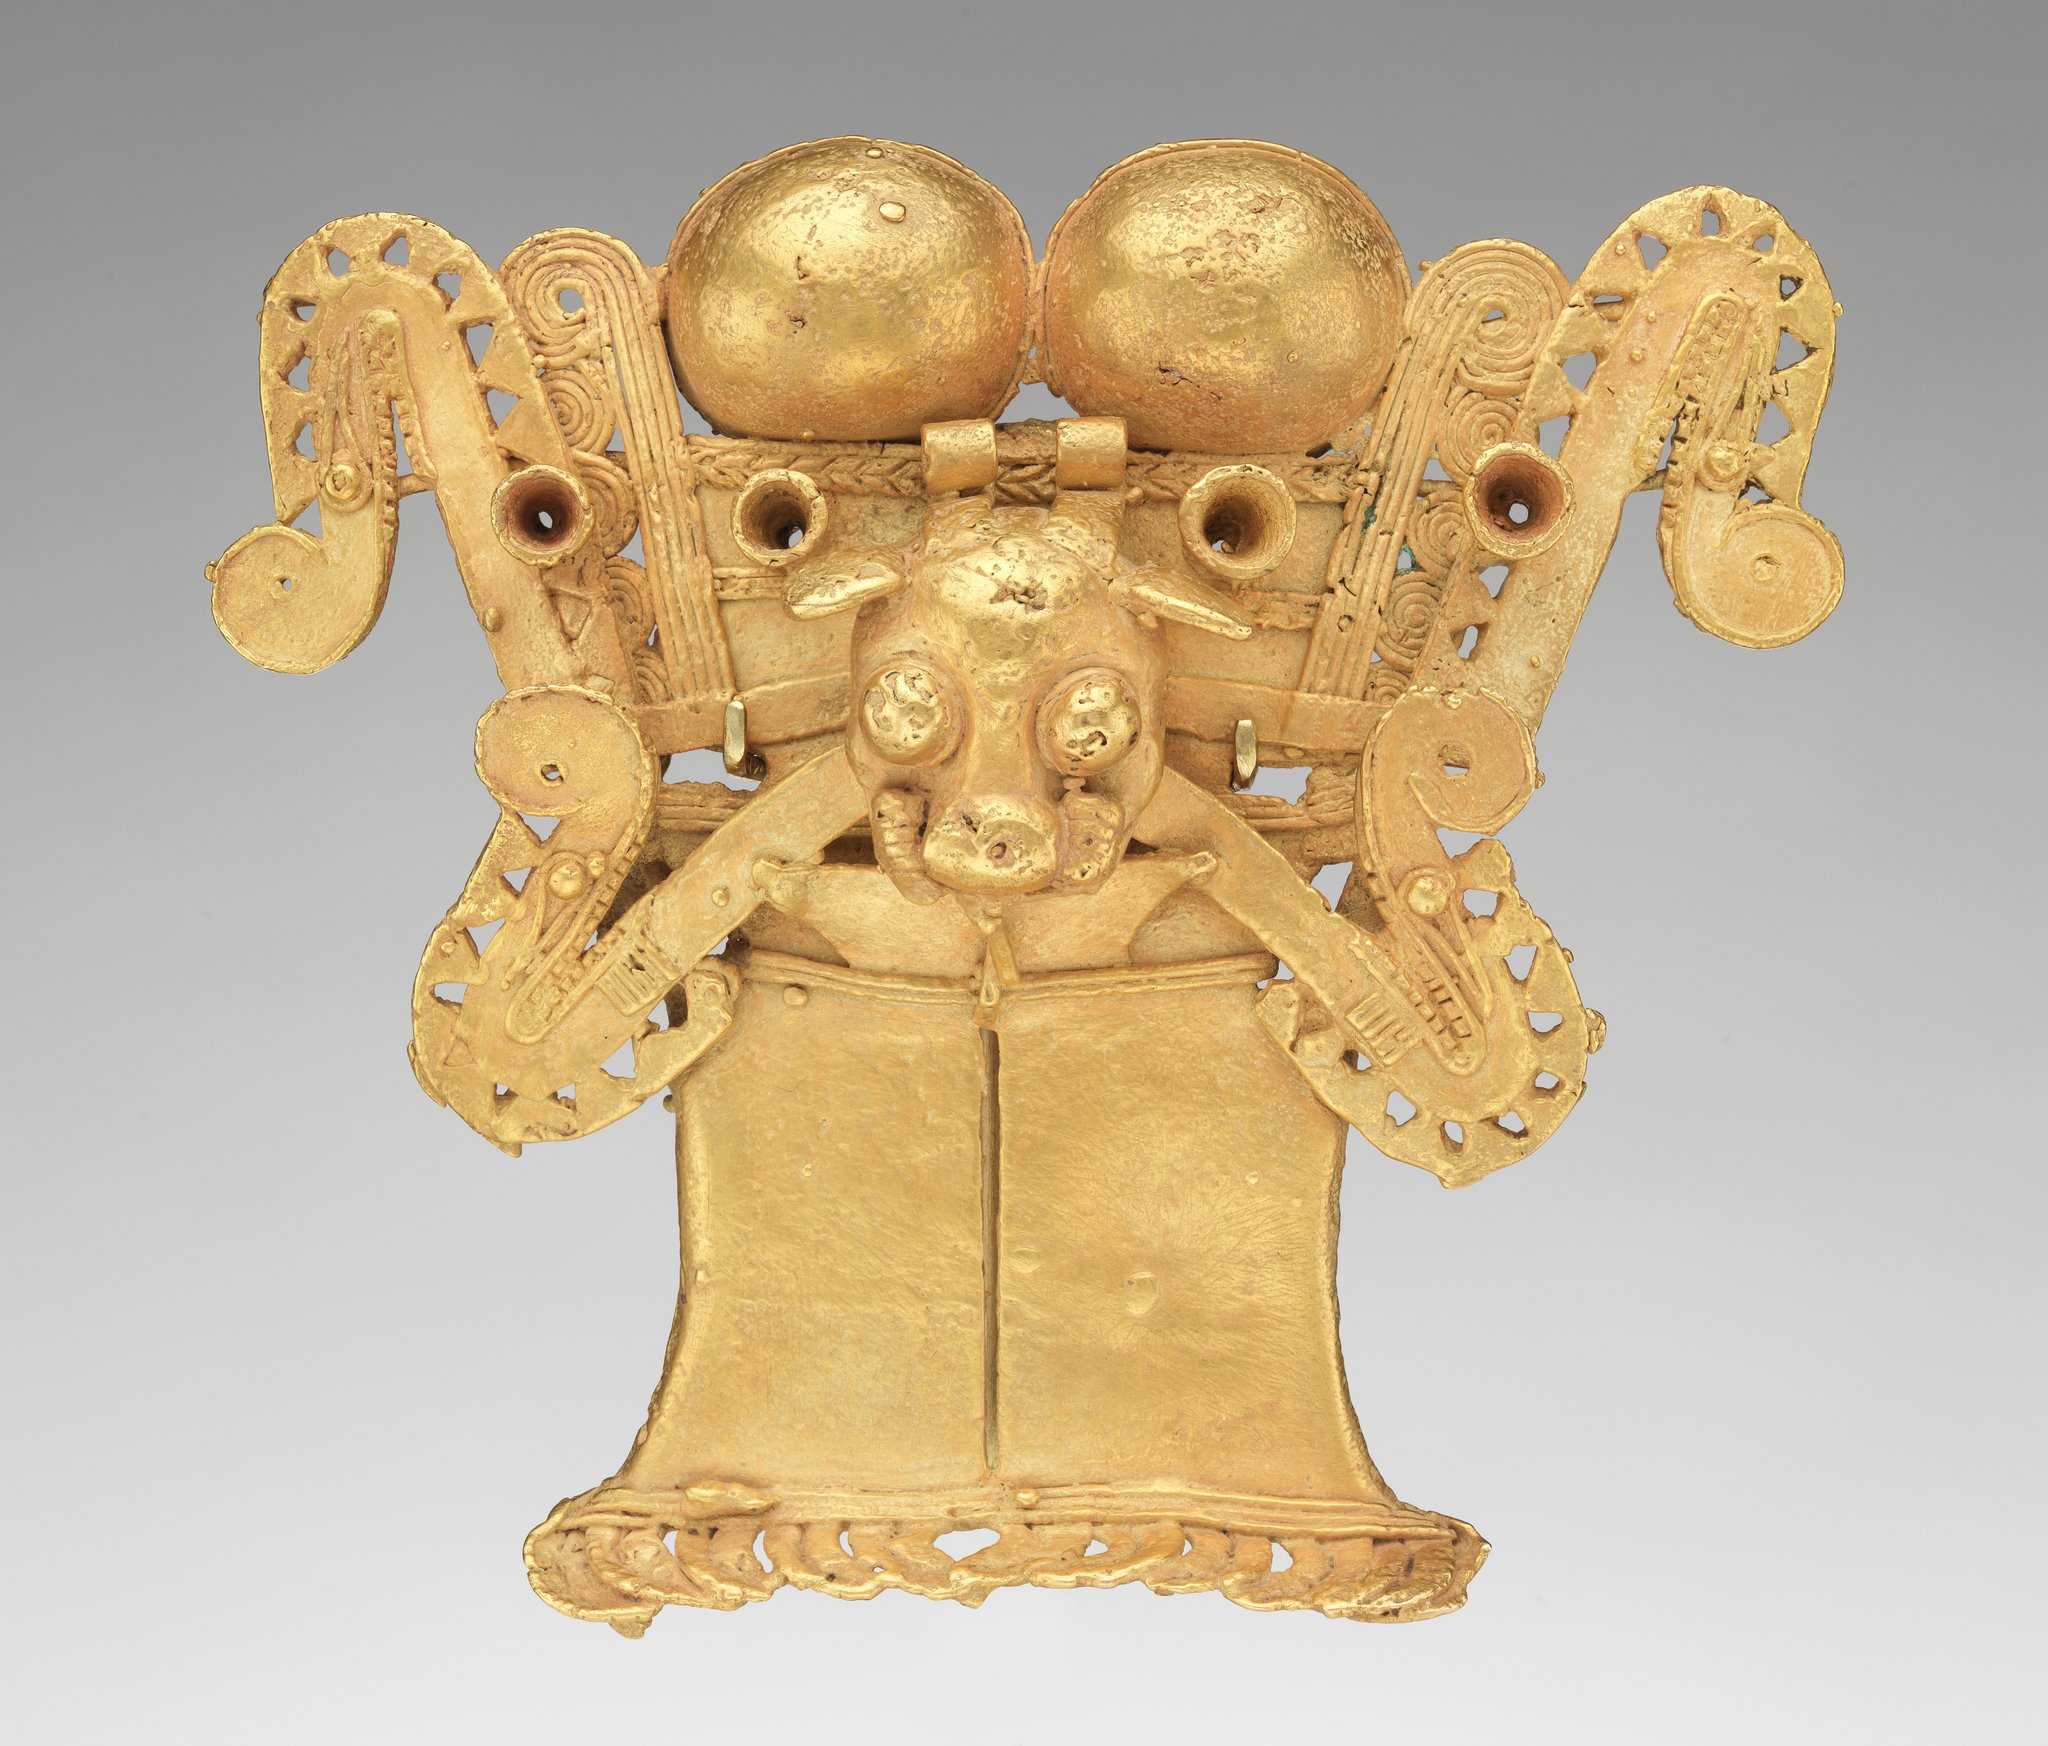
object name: pendant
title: Stylized Figure Pendant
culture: coclé, parita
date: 1101-1400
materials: gold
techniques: casting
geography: panama